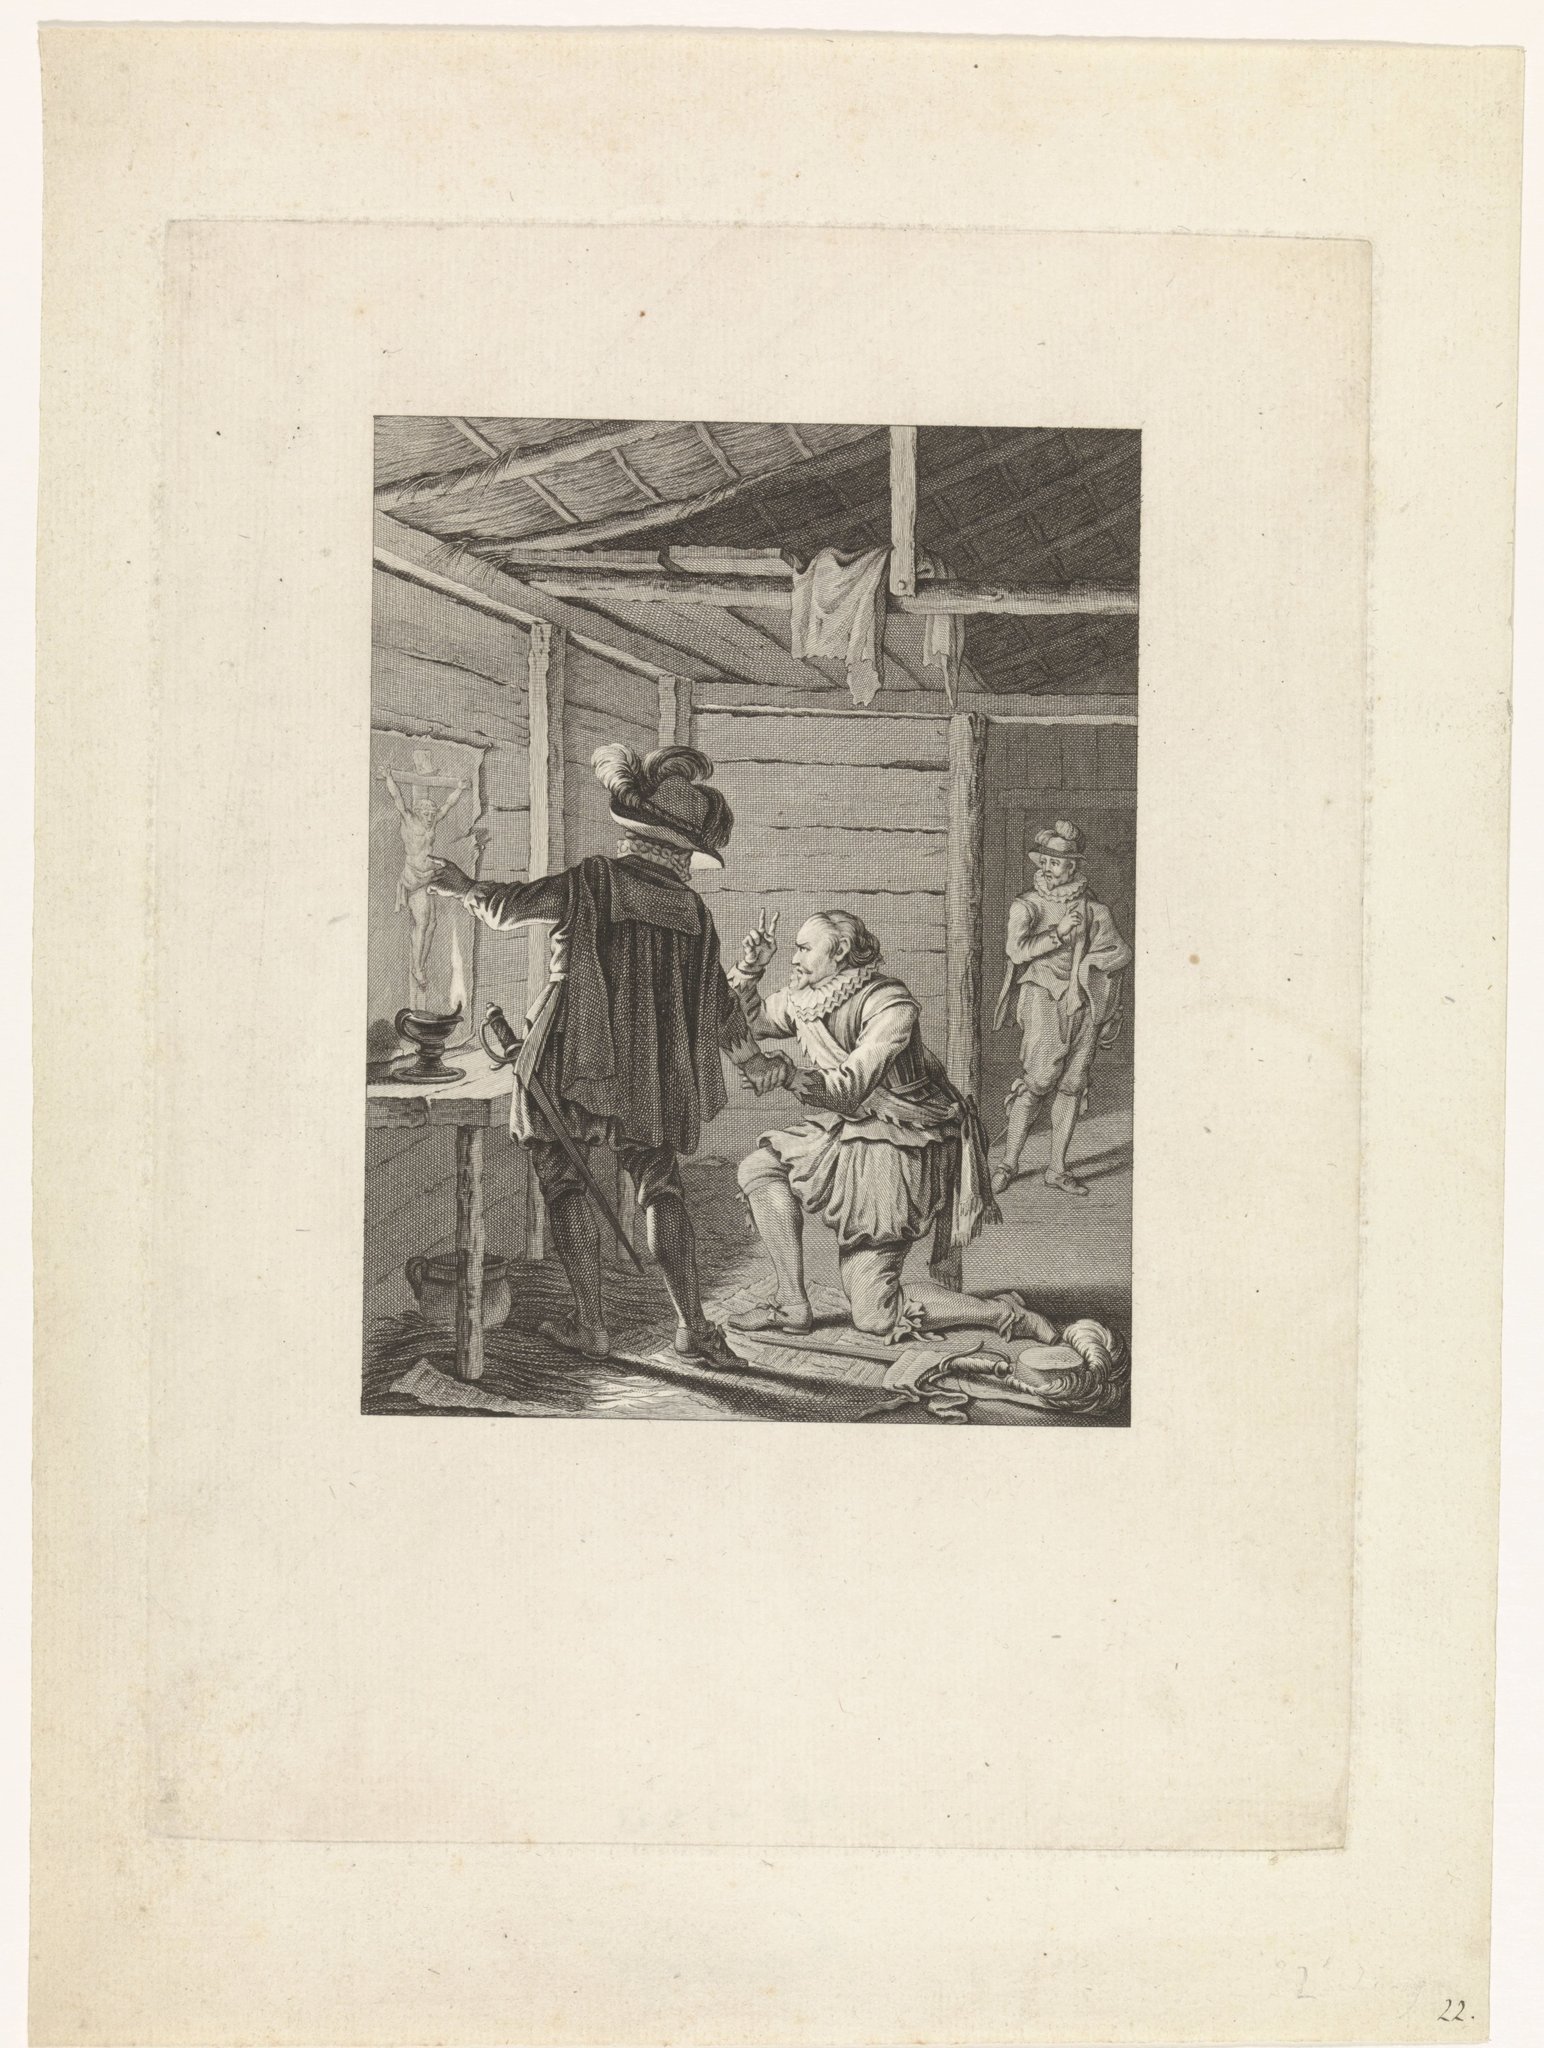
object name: print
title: & Baptizatus est a Joanne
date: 1765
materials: paper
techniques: engraving, etching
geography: southern netherlands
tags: baptism of christ in the river jordan: john the baptist pouring out water on christ's head: the holy ghost descends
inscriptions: collector's mark: Lugt 240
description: Christus wordt door Johannes de Doper in de Jordaan gedoopt. Boven Christus' hoofd verschijnen God en de Heilige Geest in de gedaante van een duif.